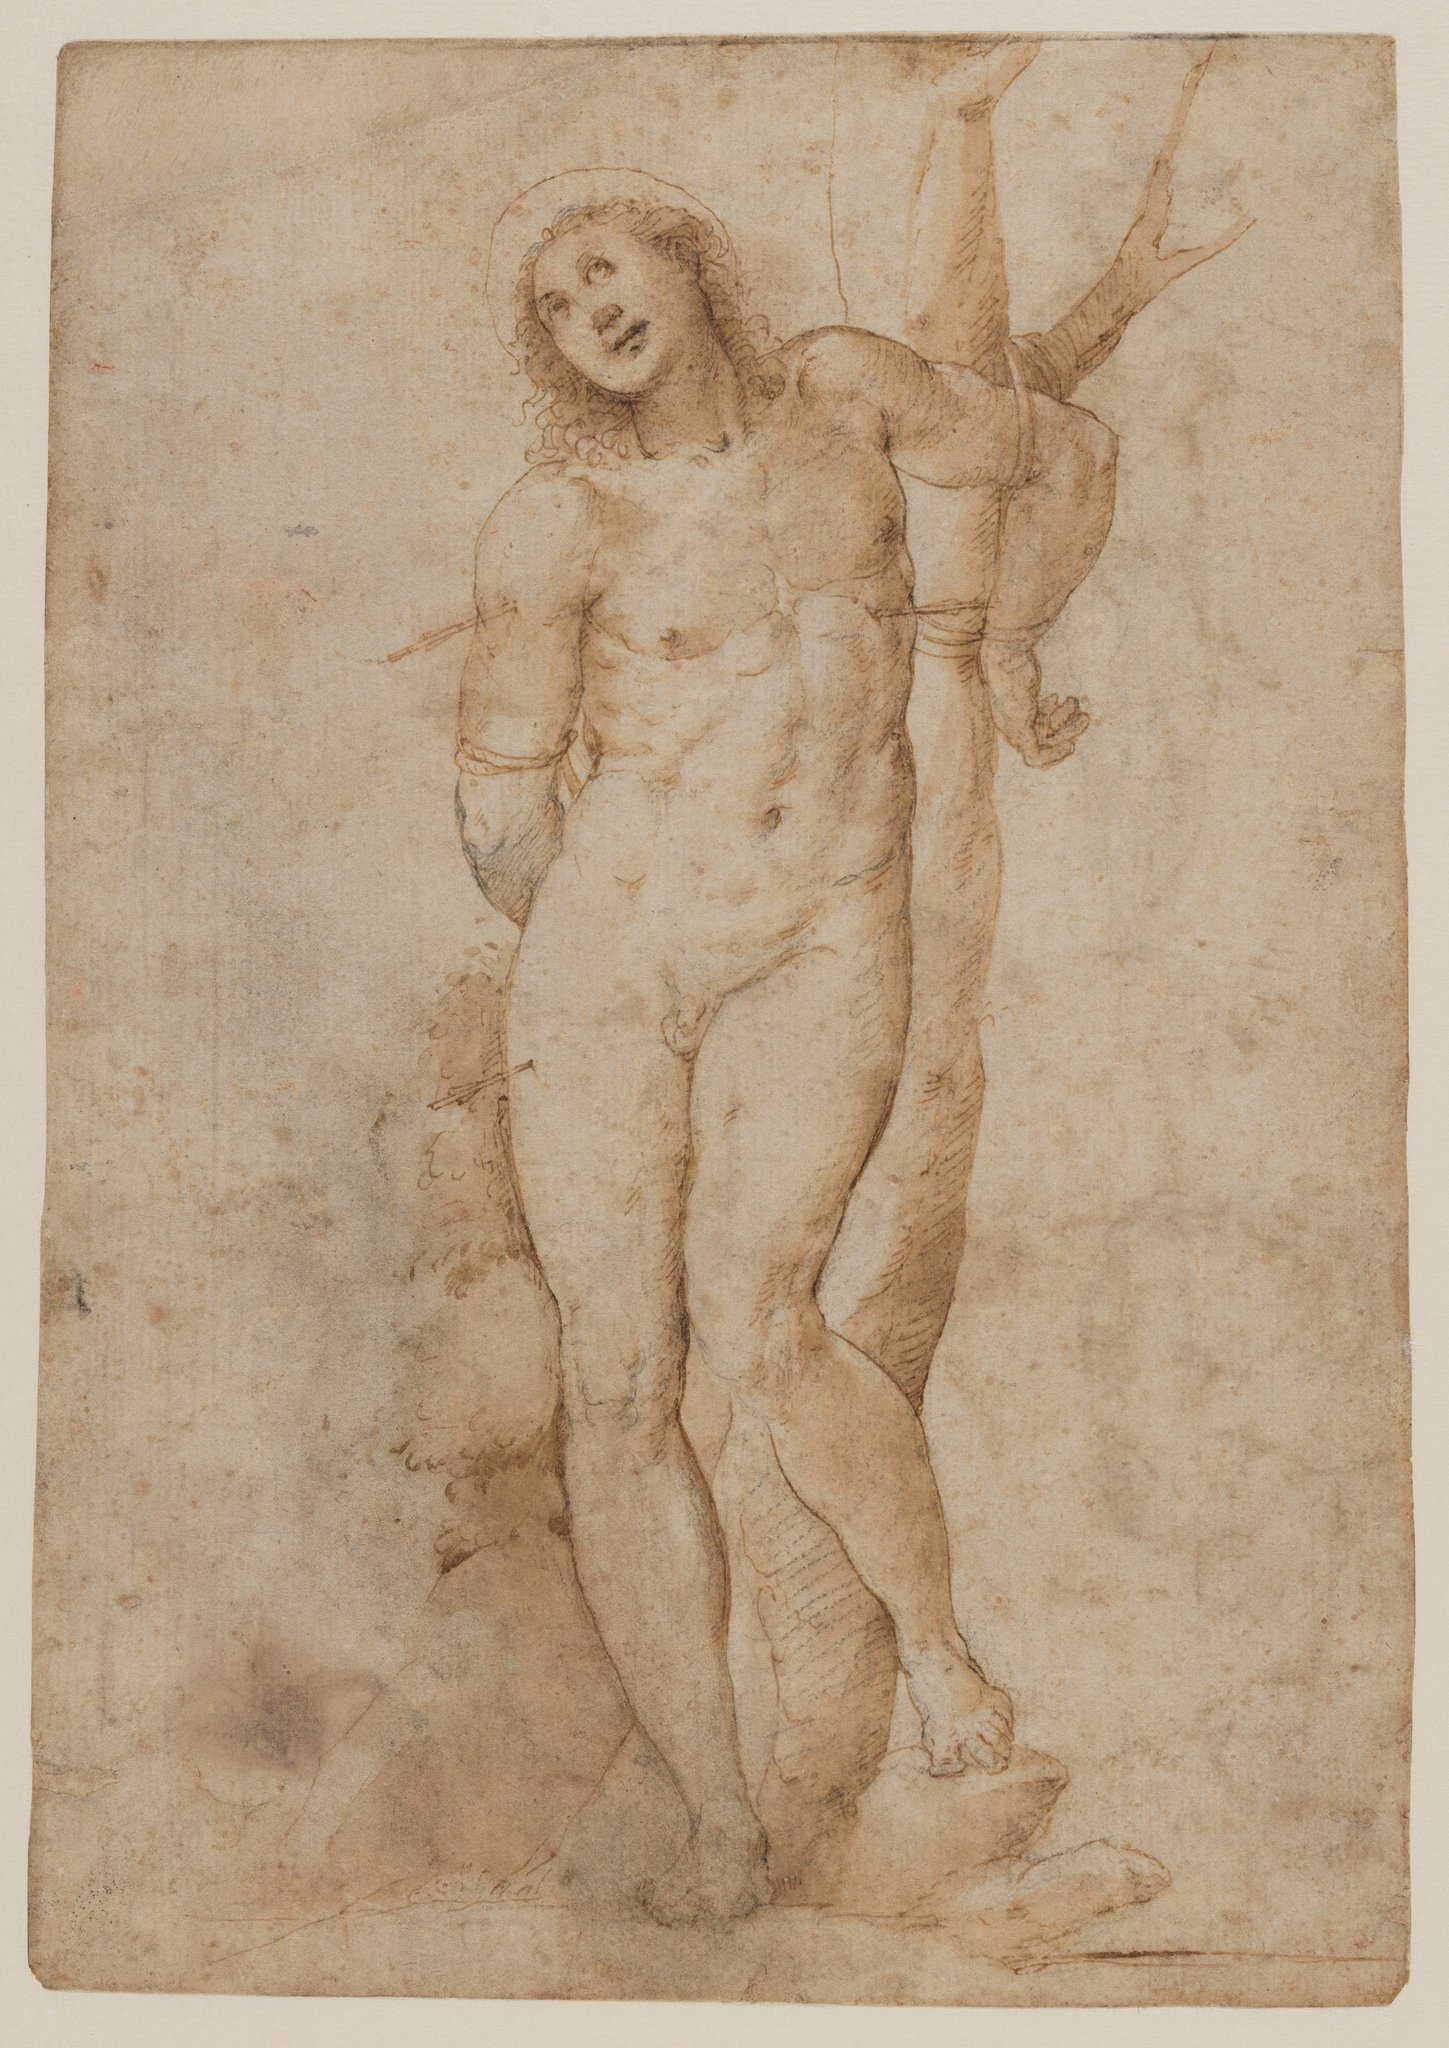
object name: drawing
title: Saint Sebastian (recto); sketches of a male head and a standing figure in a short cape; a copy of the figure on the recto (verso)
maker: sodoma (giovanni antonio bazzi)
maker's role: artist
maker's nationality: italian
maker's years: 1477-1549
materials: chalk, ink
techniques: pen, wash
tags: saint sebastian